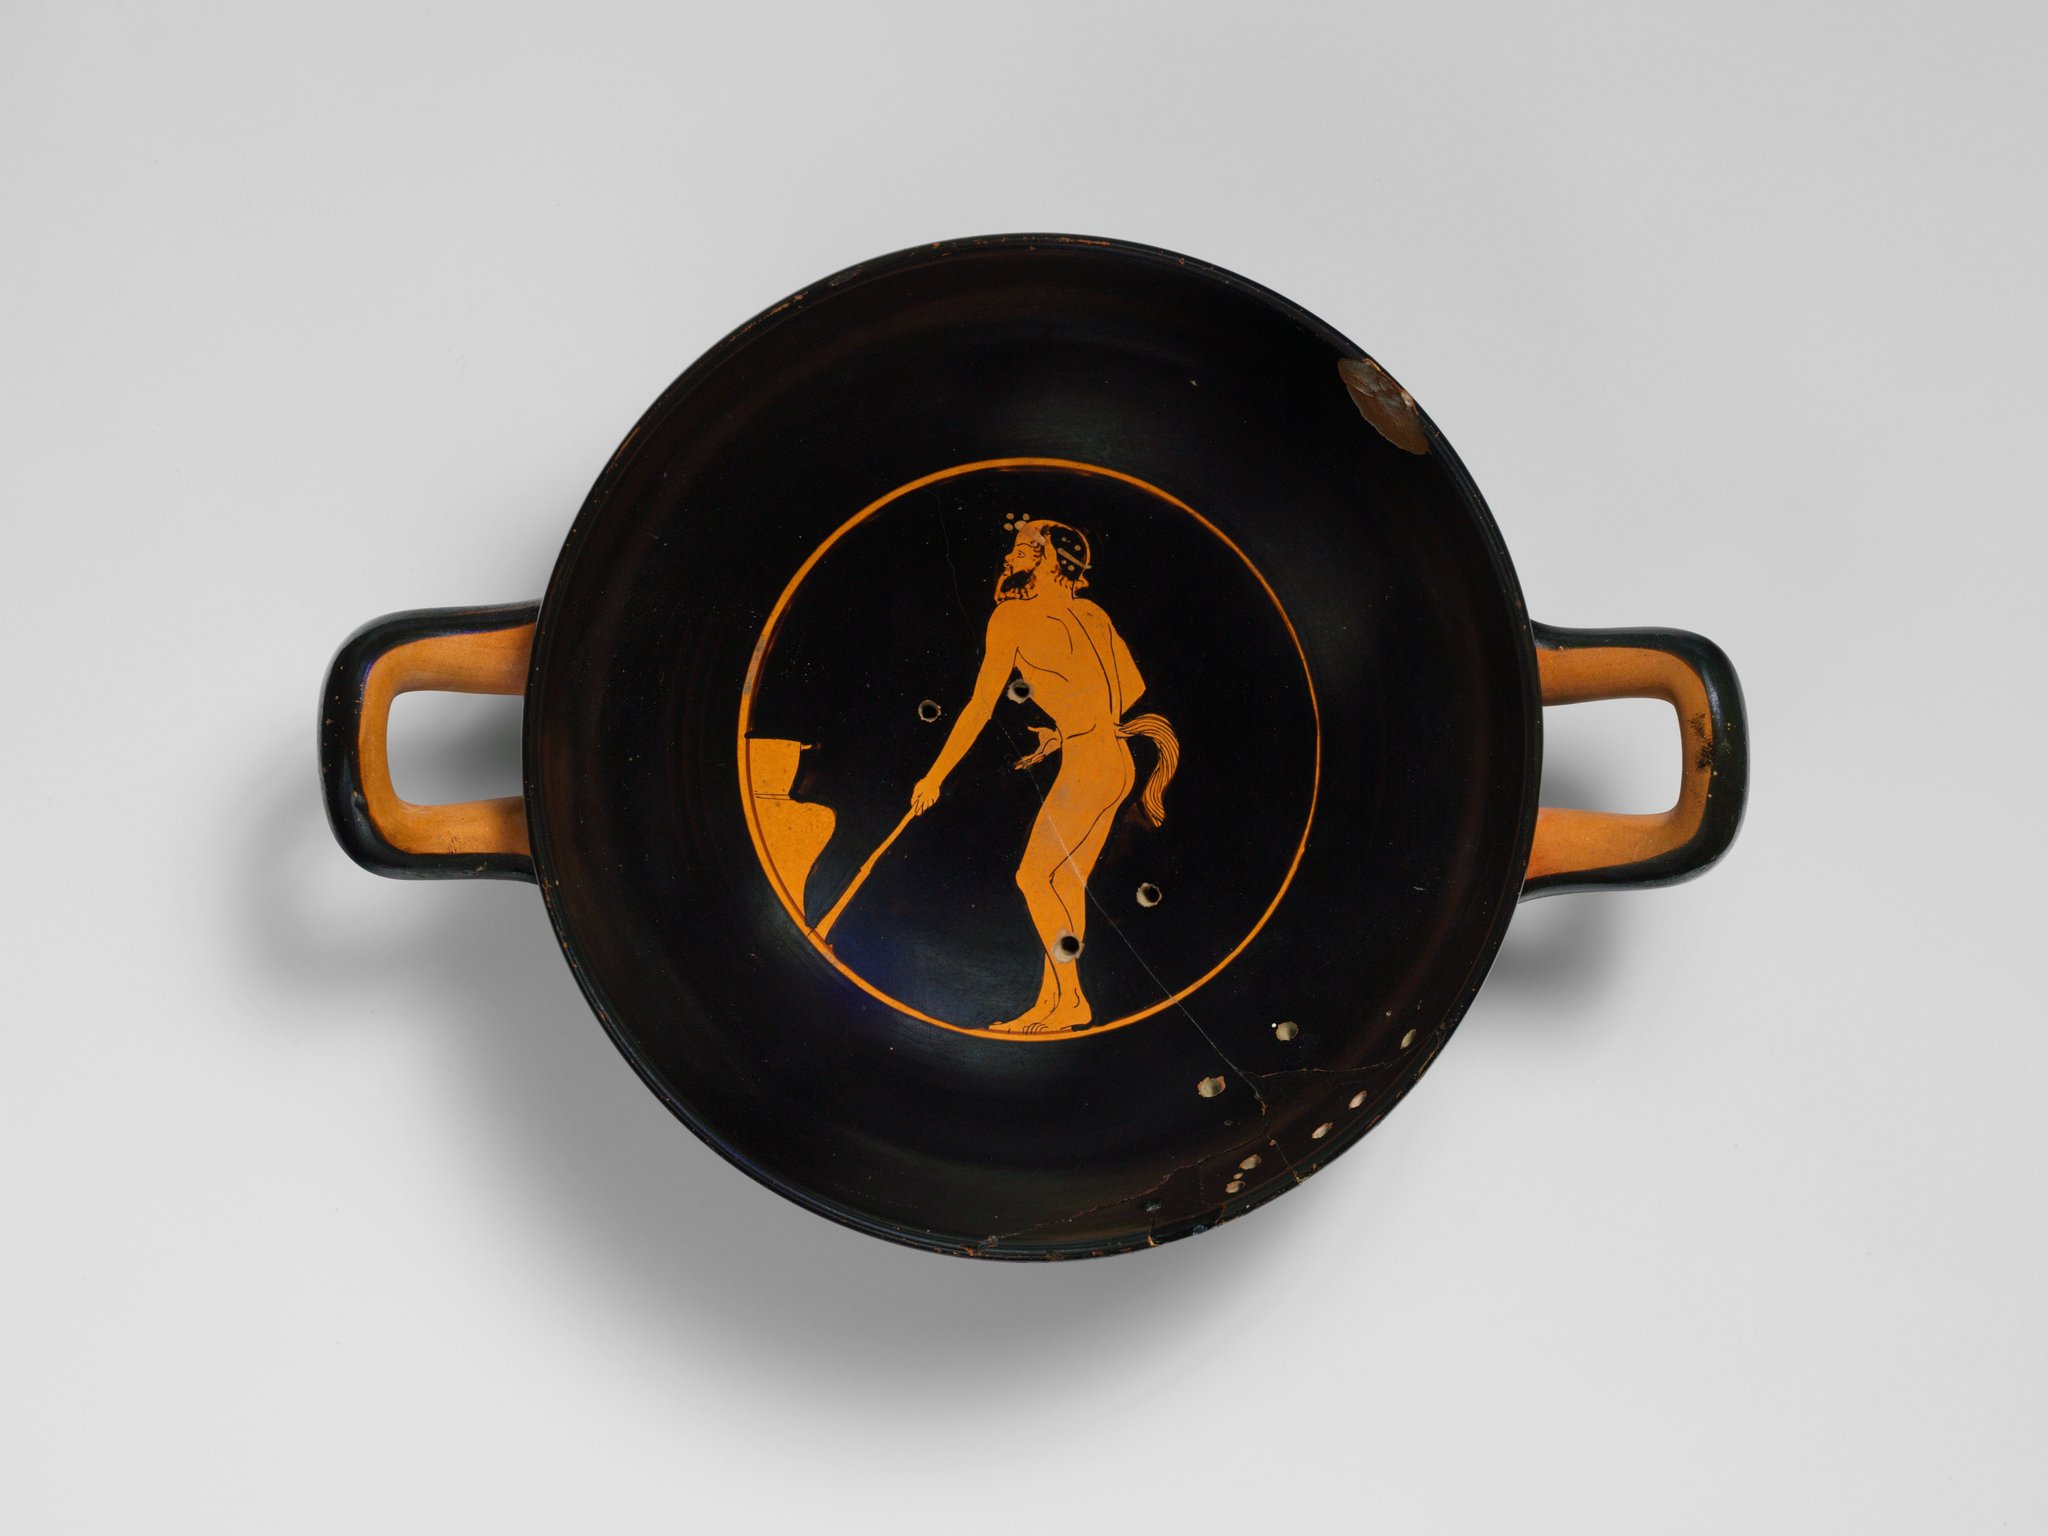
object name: kylix, stemless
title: Terracotta kylix (drinking cup)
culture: greek, attic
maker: euaion painter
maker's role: artist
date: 460-450 BCE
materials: terracotta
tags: satyrs